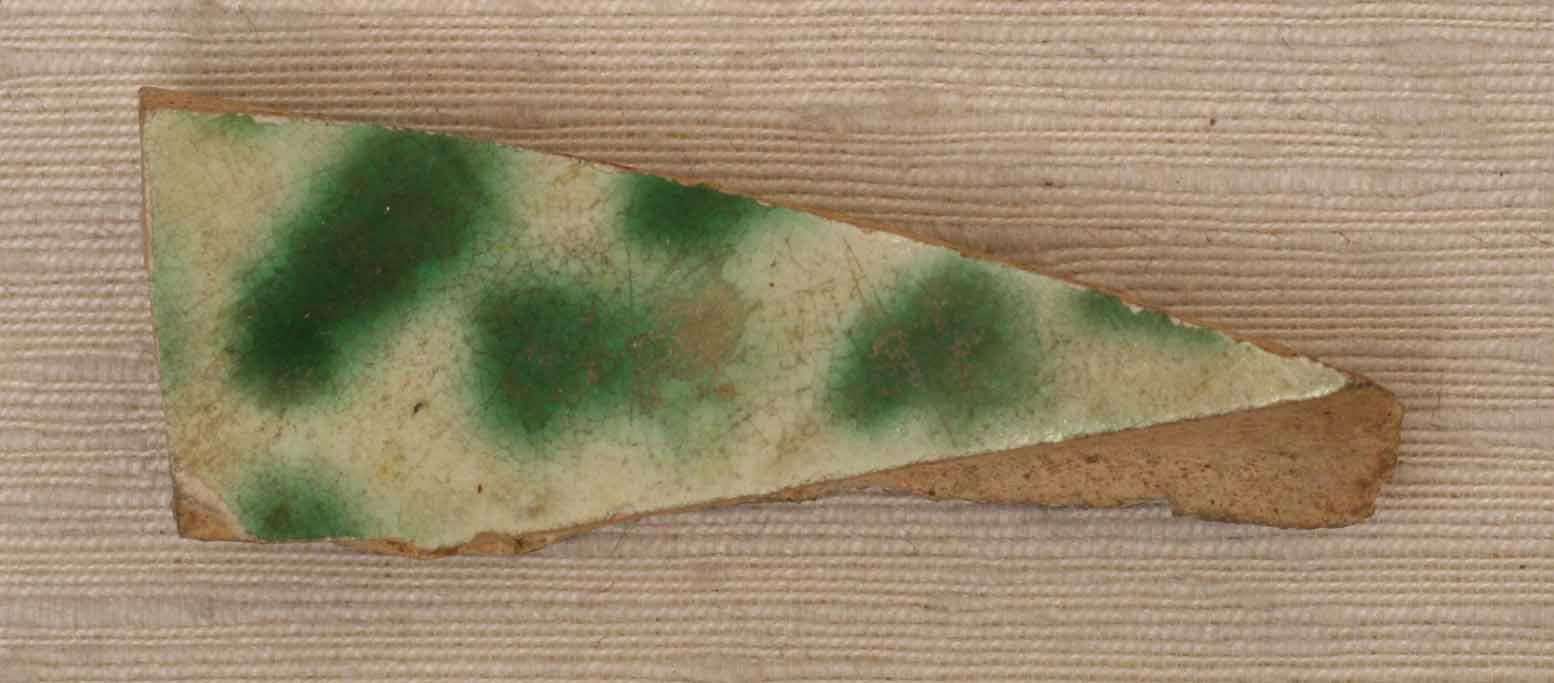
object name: fragment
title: Fragments of Splashed Ceramic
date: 801-900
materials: earthenware, glaze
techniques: painting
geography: iraq